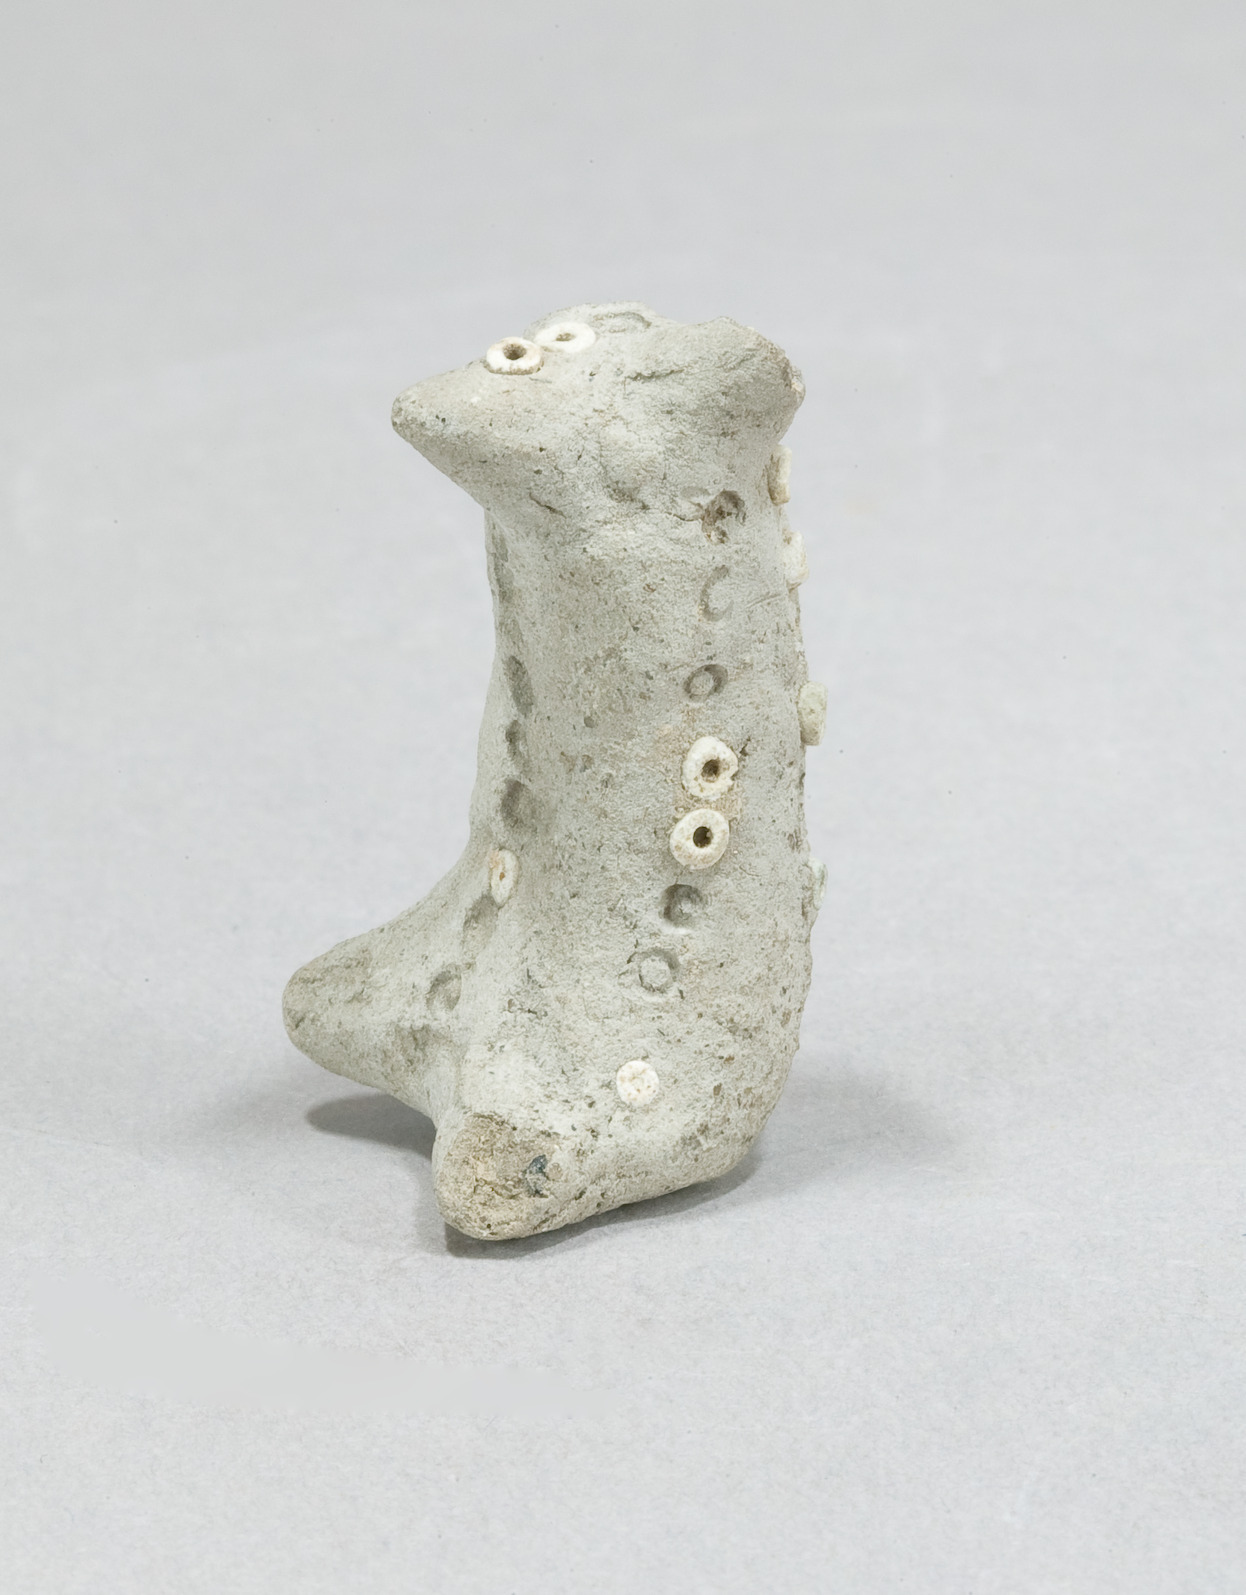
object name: figurine, animal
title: Animal figure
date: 1850-1640 BCE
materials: faience, mud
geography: egypt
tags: animals